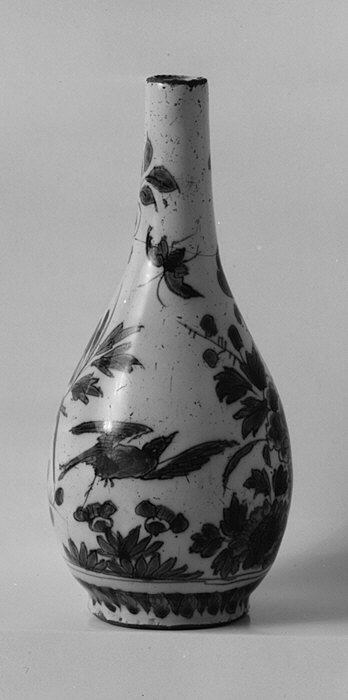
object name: vase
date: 1701-1733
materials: earthenware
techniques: glazing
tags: birds,flowers